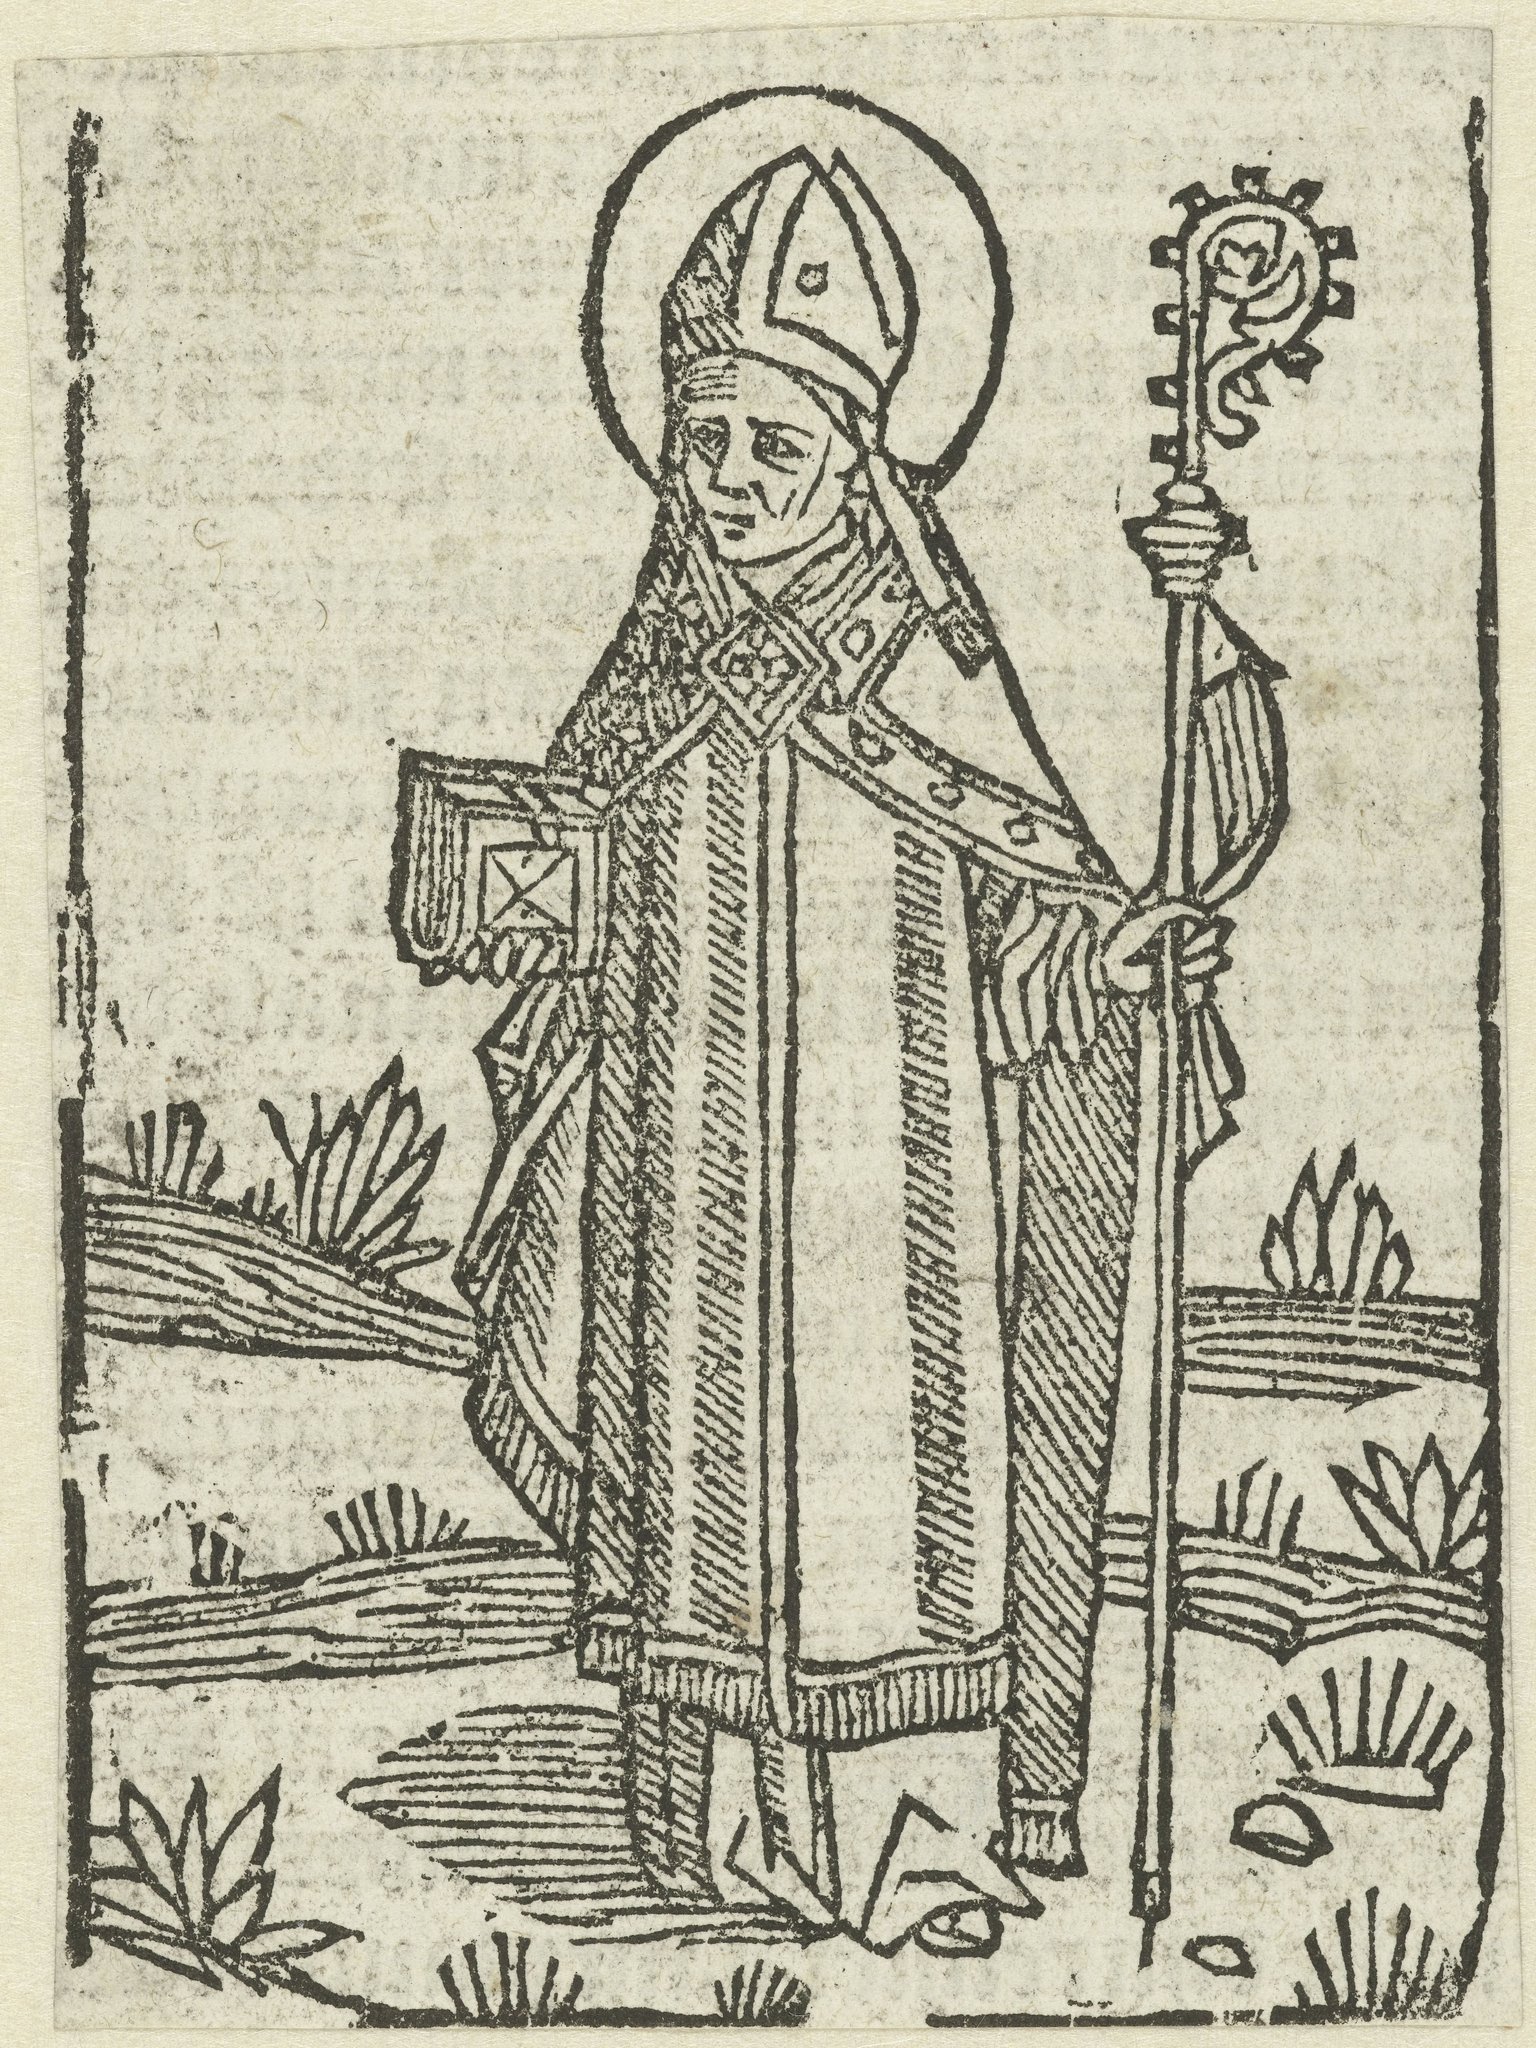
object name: book illustration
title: Heilige bisschop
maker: Anonymous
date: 1490-1510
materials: paper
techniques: woodcut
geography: low countries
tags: archbishop, bishop, etc. (roman catholic), book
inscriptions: collector's mark: Lugt 2228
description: Blad uit een boek. Onbekende heilige bisschop met staf en boek.